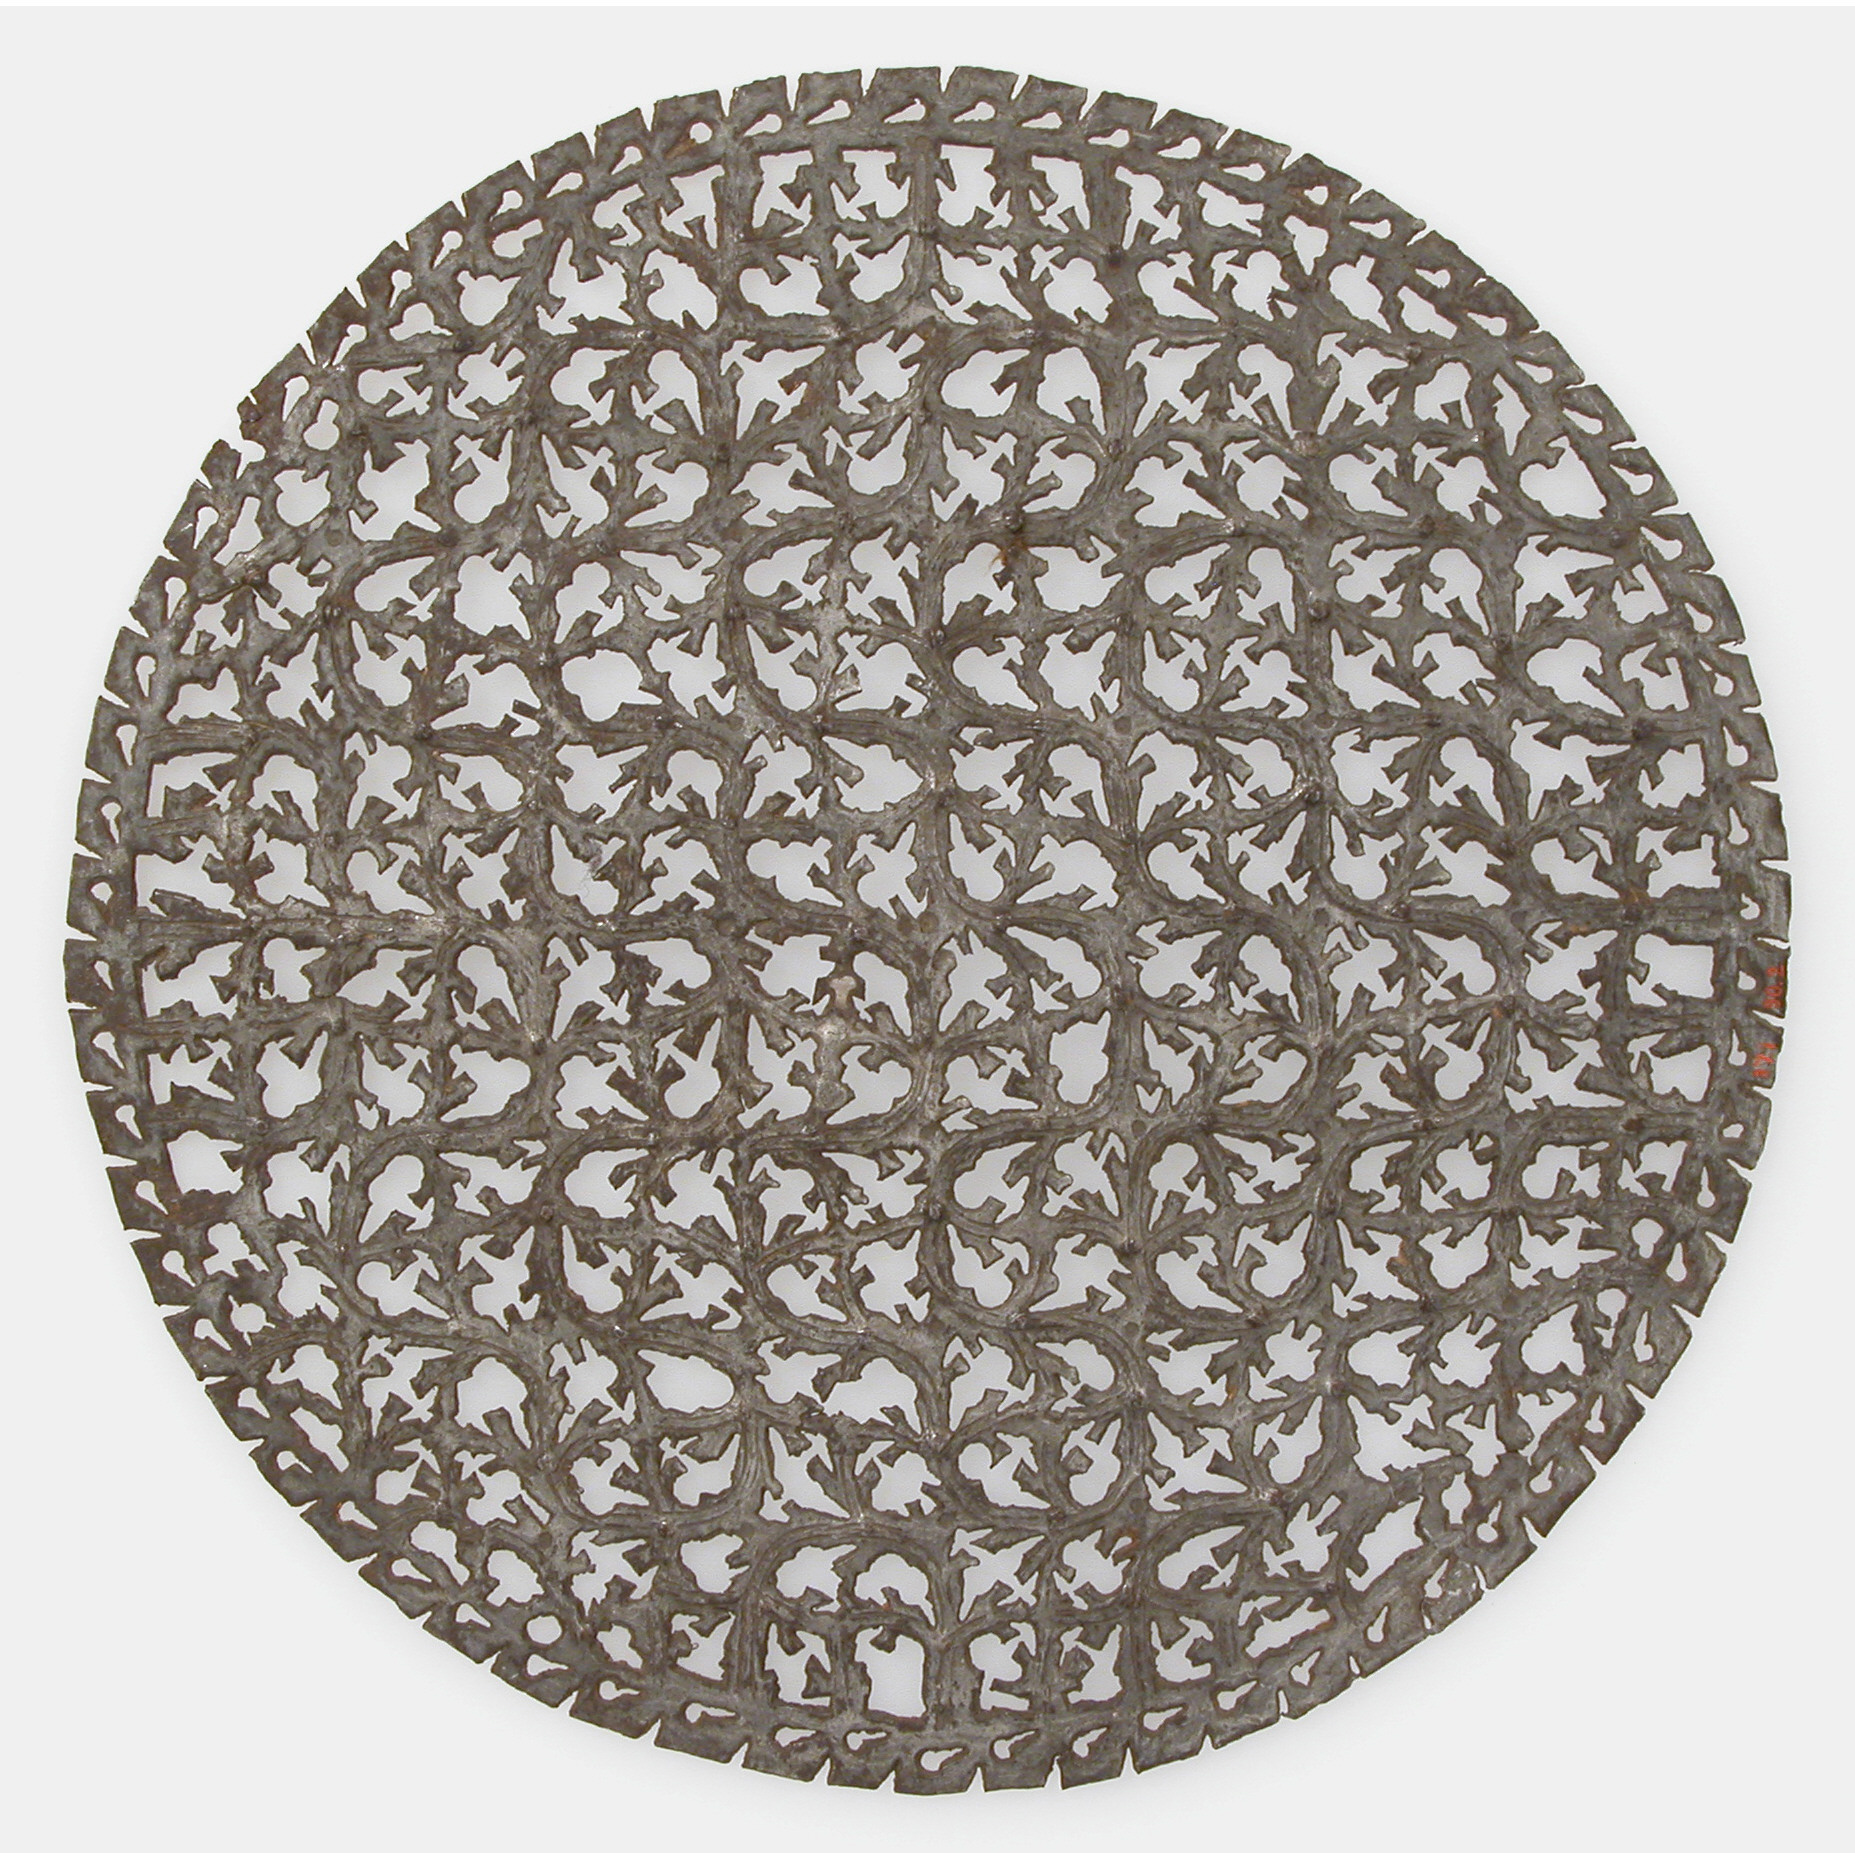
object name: plaque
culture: german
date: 1401-1600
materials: iron